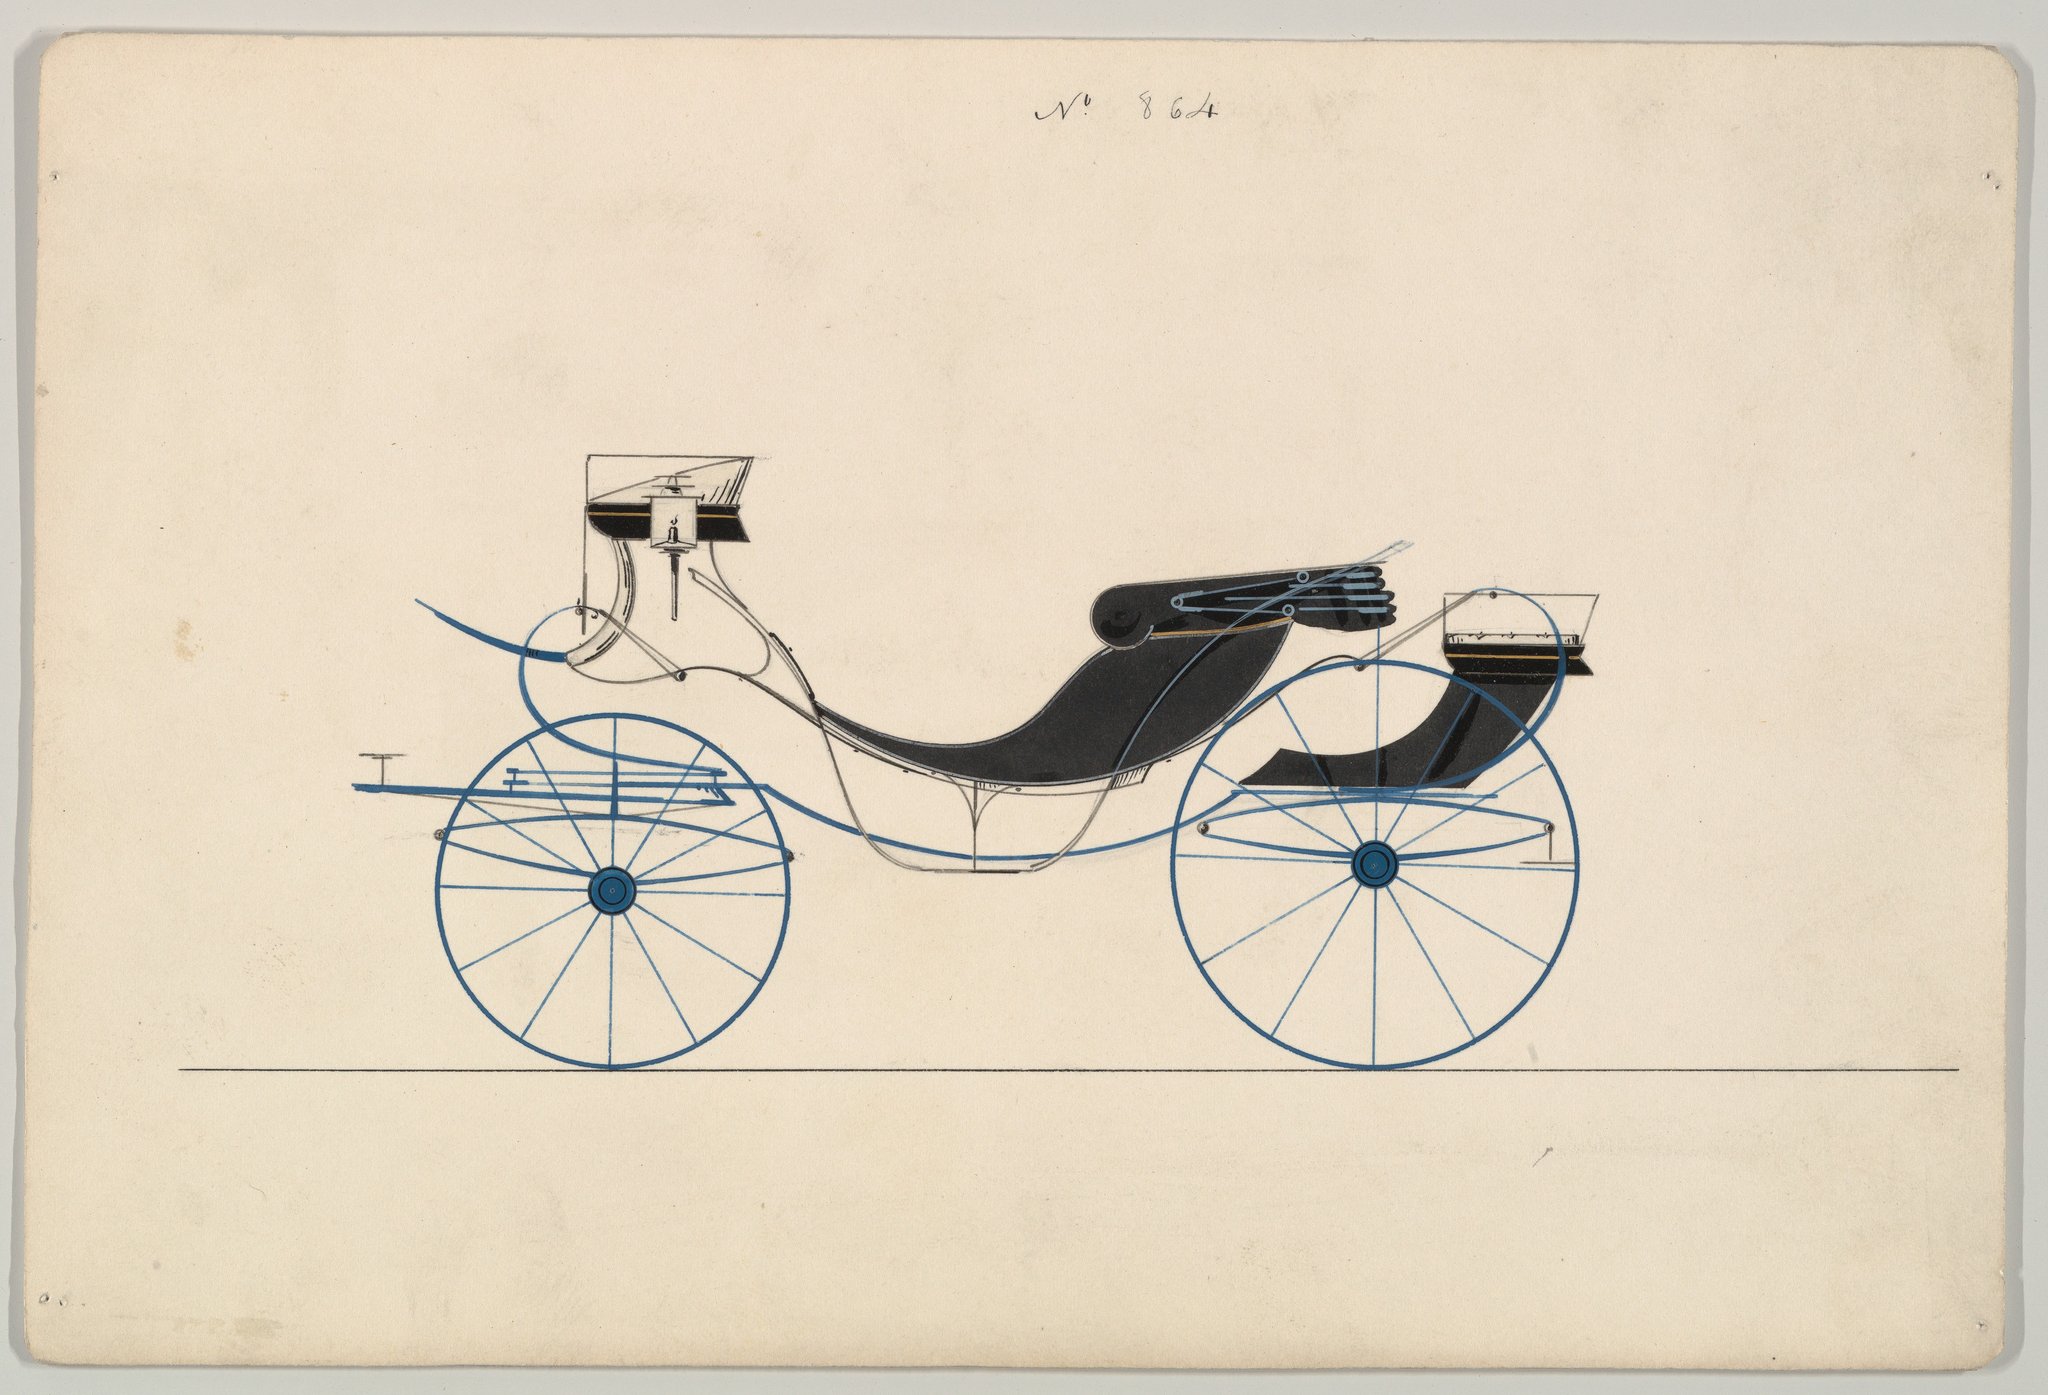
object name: drawing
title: Eight Spring Victoria #864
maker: brewster & co.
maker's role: manufacturer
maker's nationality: american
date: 1850-1874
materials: gouache, gum arabic, ink, watercolor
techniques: pen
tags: carriages